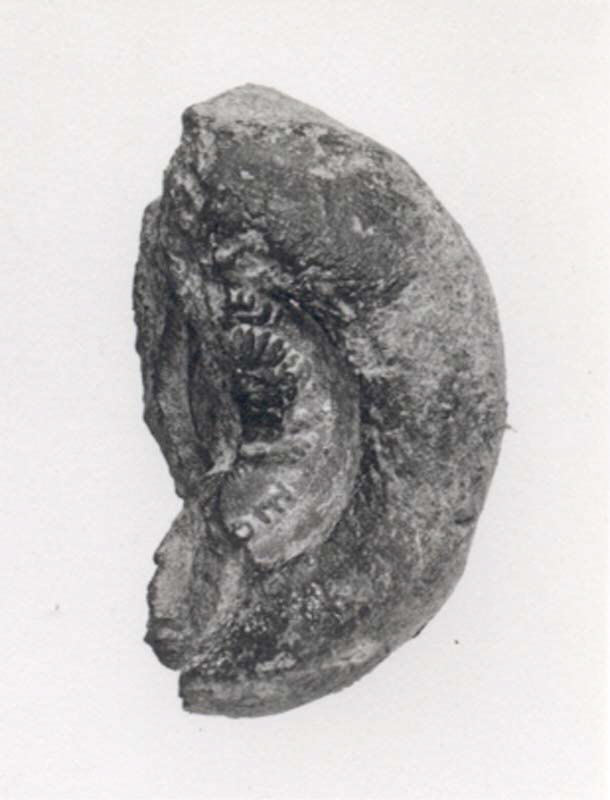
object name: sealing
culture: sasanian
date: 601-700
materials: clay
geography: iran